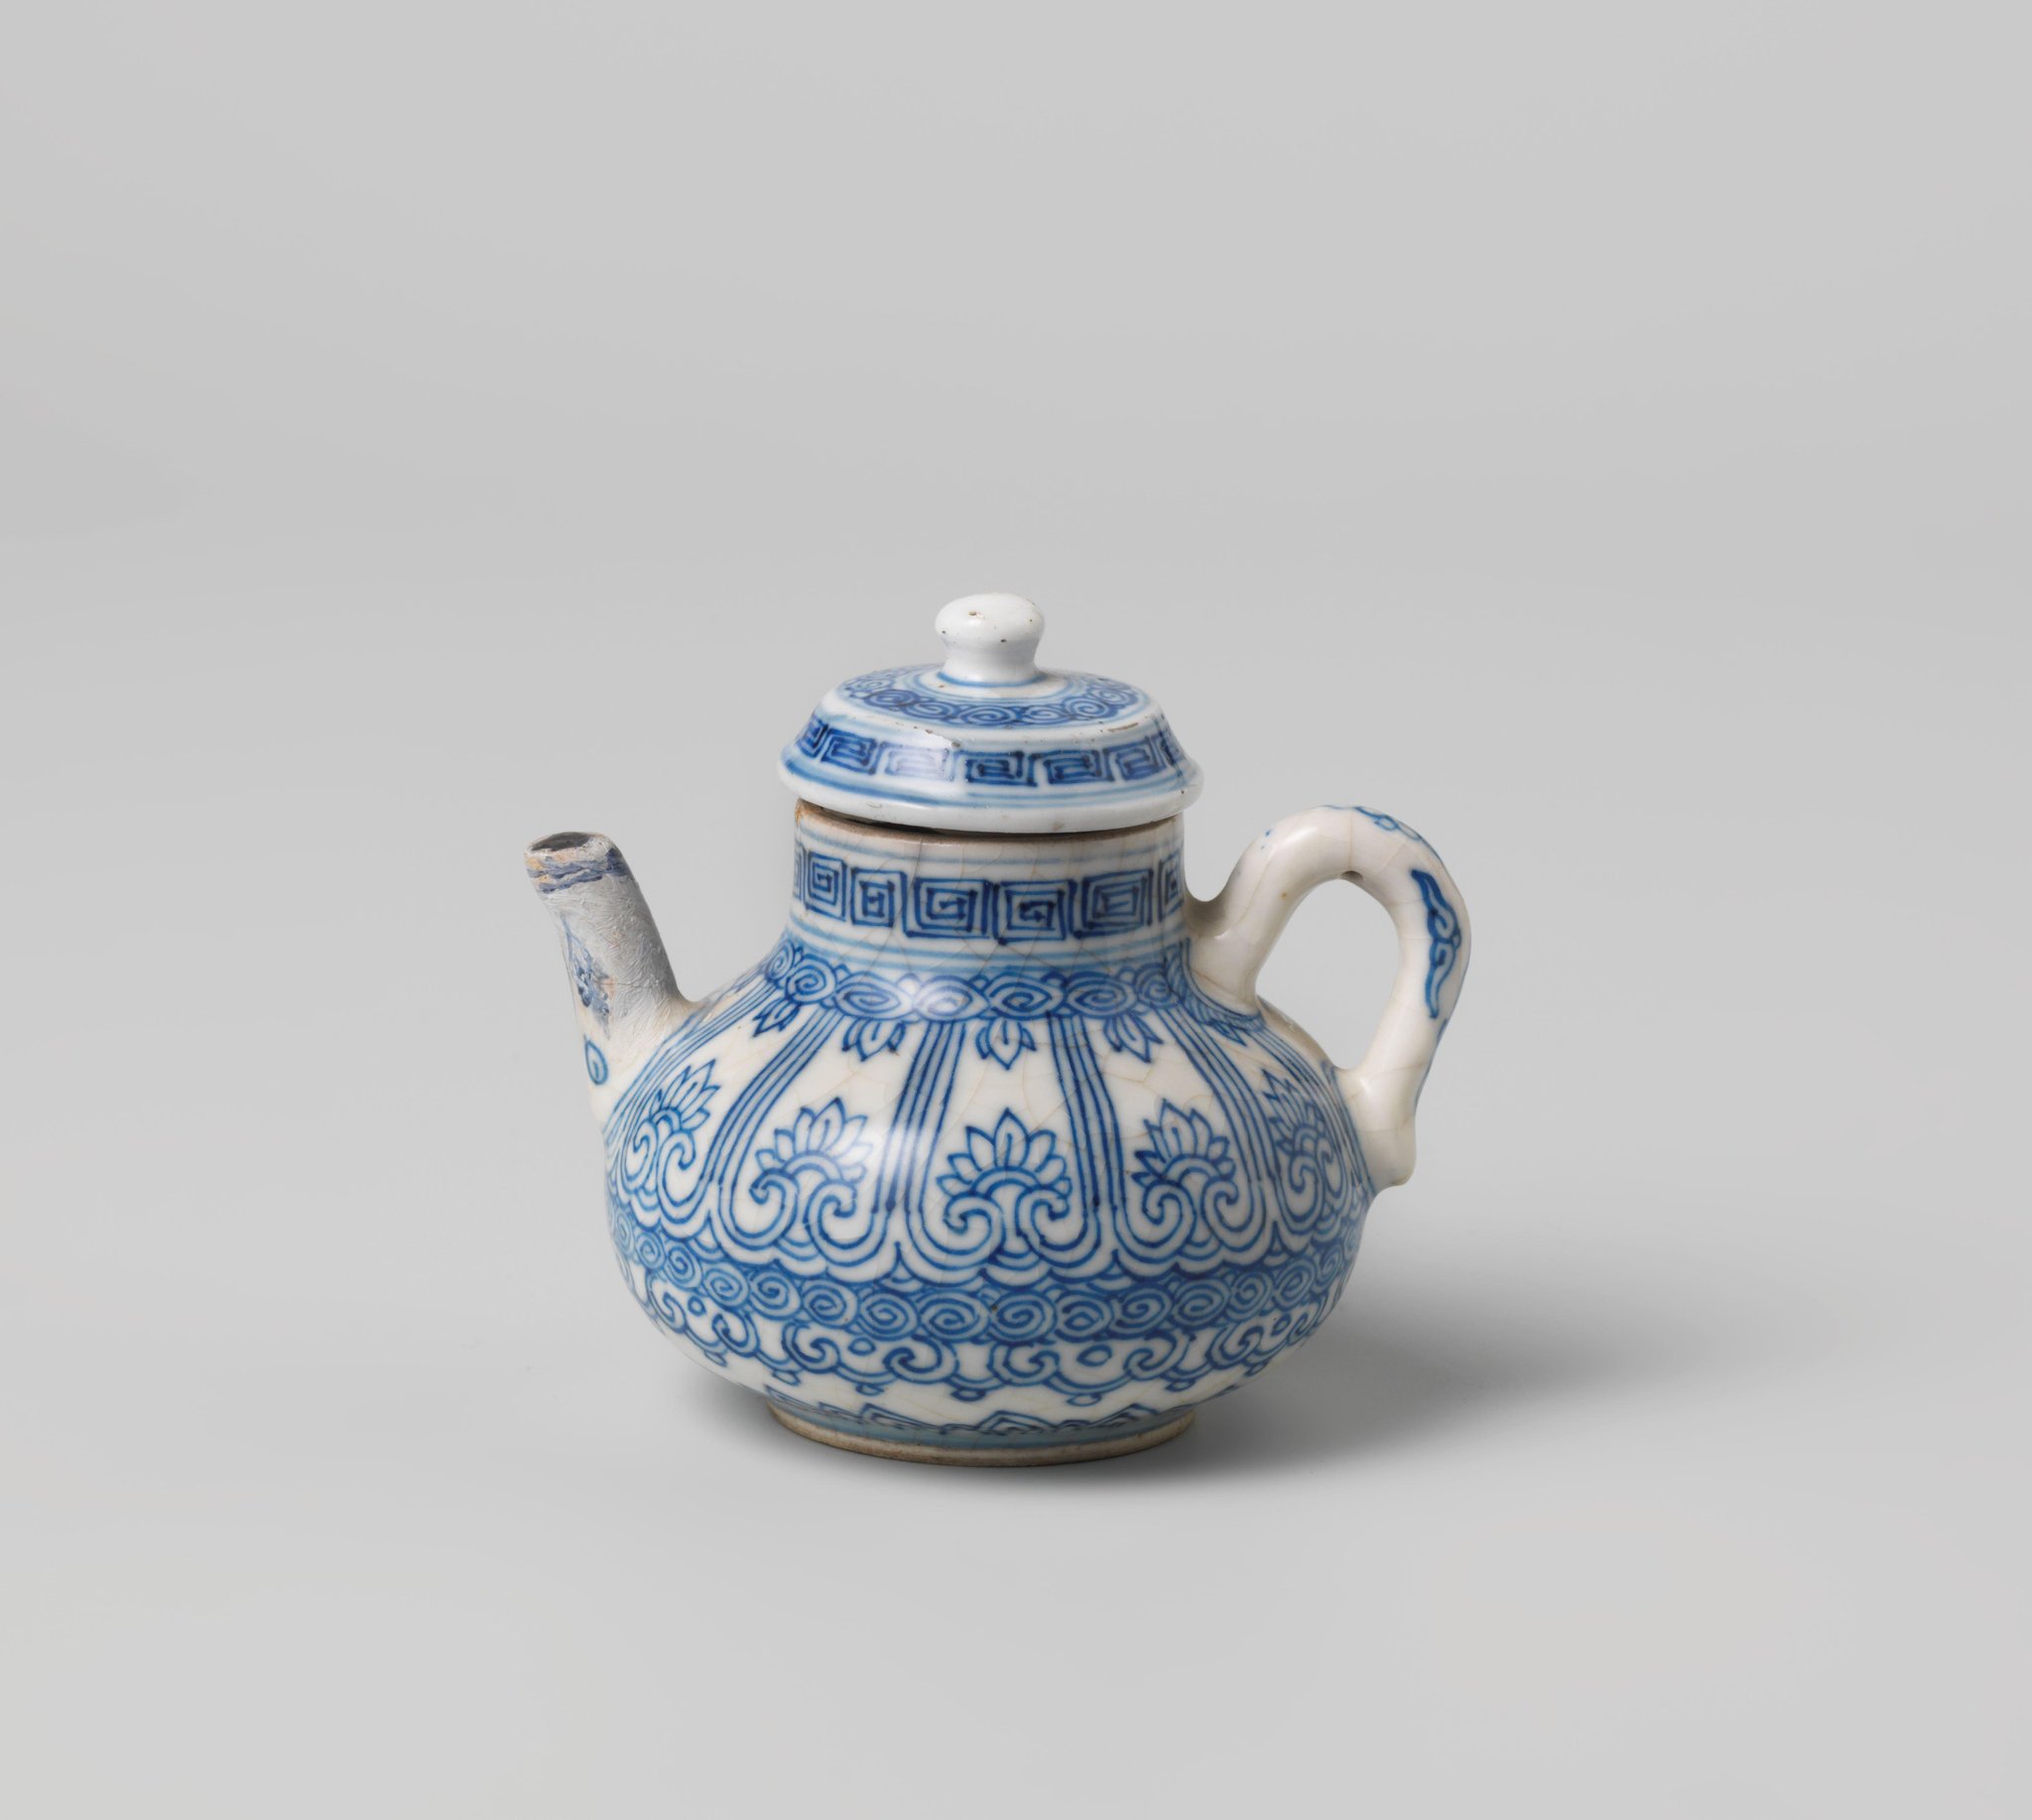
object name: teapot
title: Teapot with stylized lotus scrolls, ruyi-motif and ornamental borders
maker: Anonymous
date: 1700-1724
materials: cobalt, glaze, paint, porcelain, soft paste porcelain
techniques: firing, turning, vitrification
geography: china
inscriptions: mark: ‘玉’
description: Kleine theepot met een gedrukte peervorm, op een standring; een korte vrijwel rechte tuit, een hoog opgaand oor, een bolle deksel met dekselknop. Beschilderd in onderglazuur blauw met velden met gestileerde lotusranken en met banden met ruyi- en wolkmotieven. Oor en tuit gebroken.